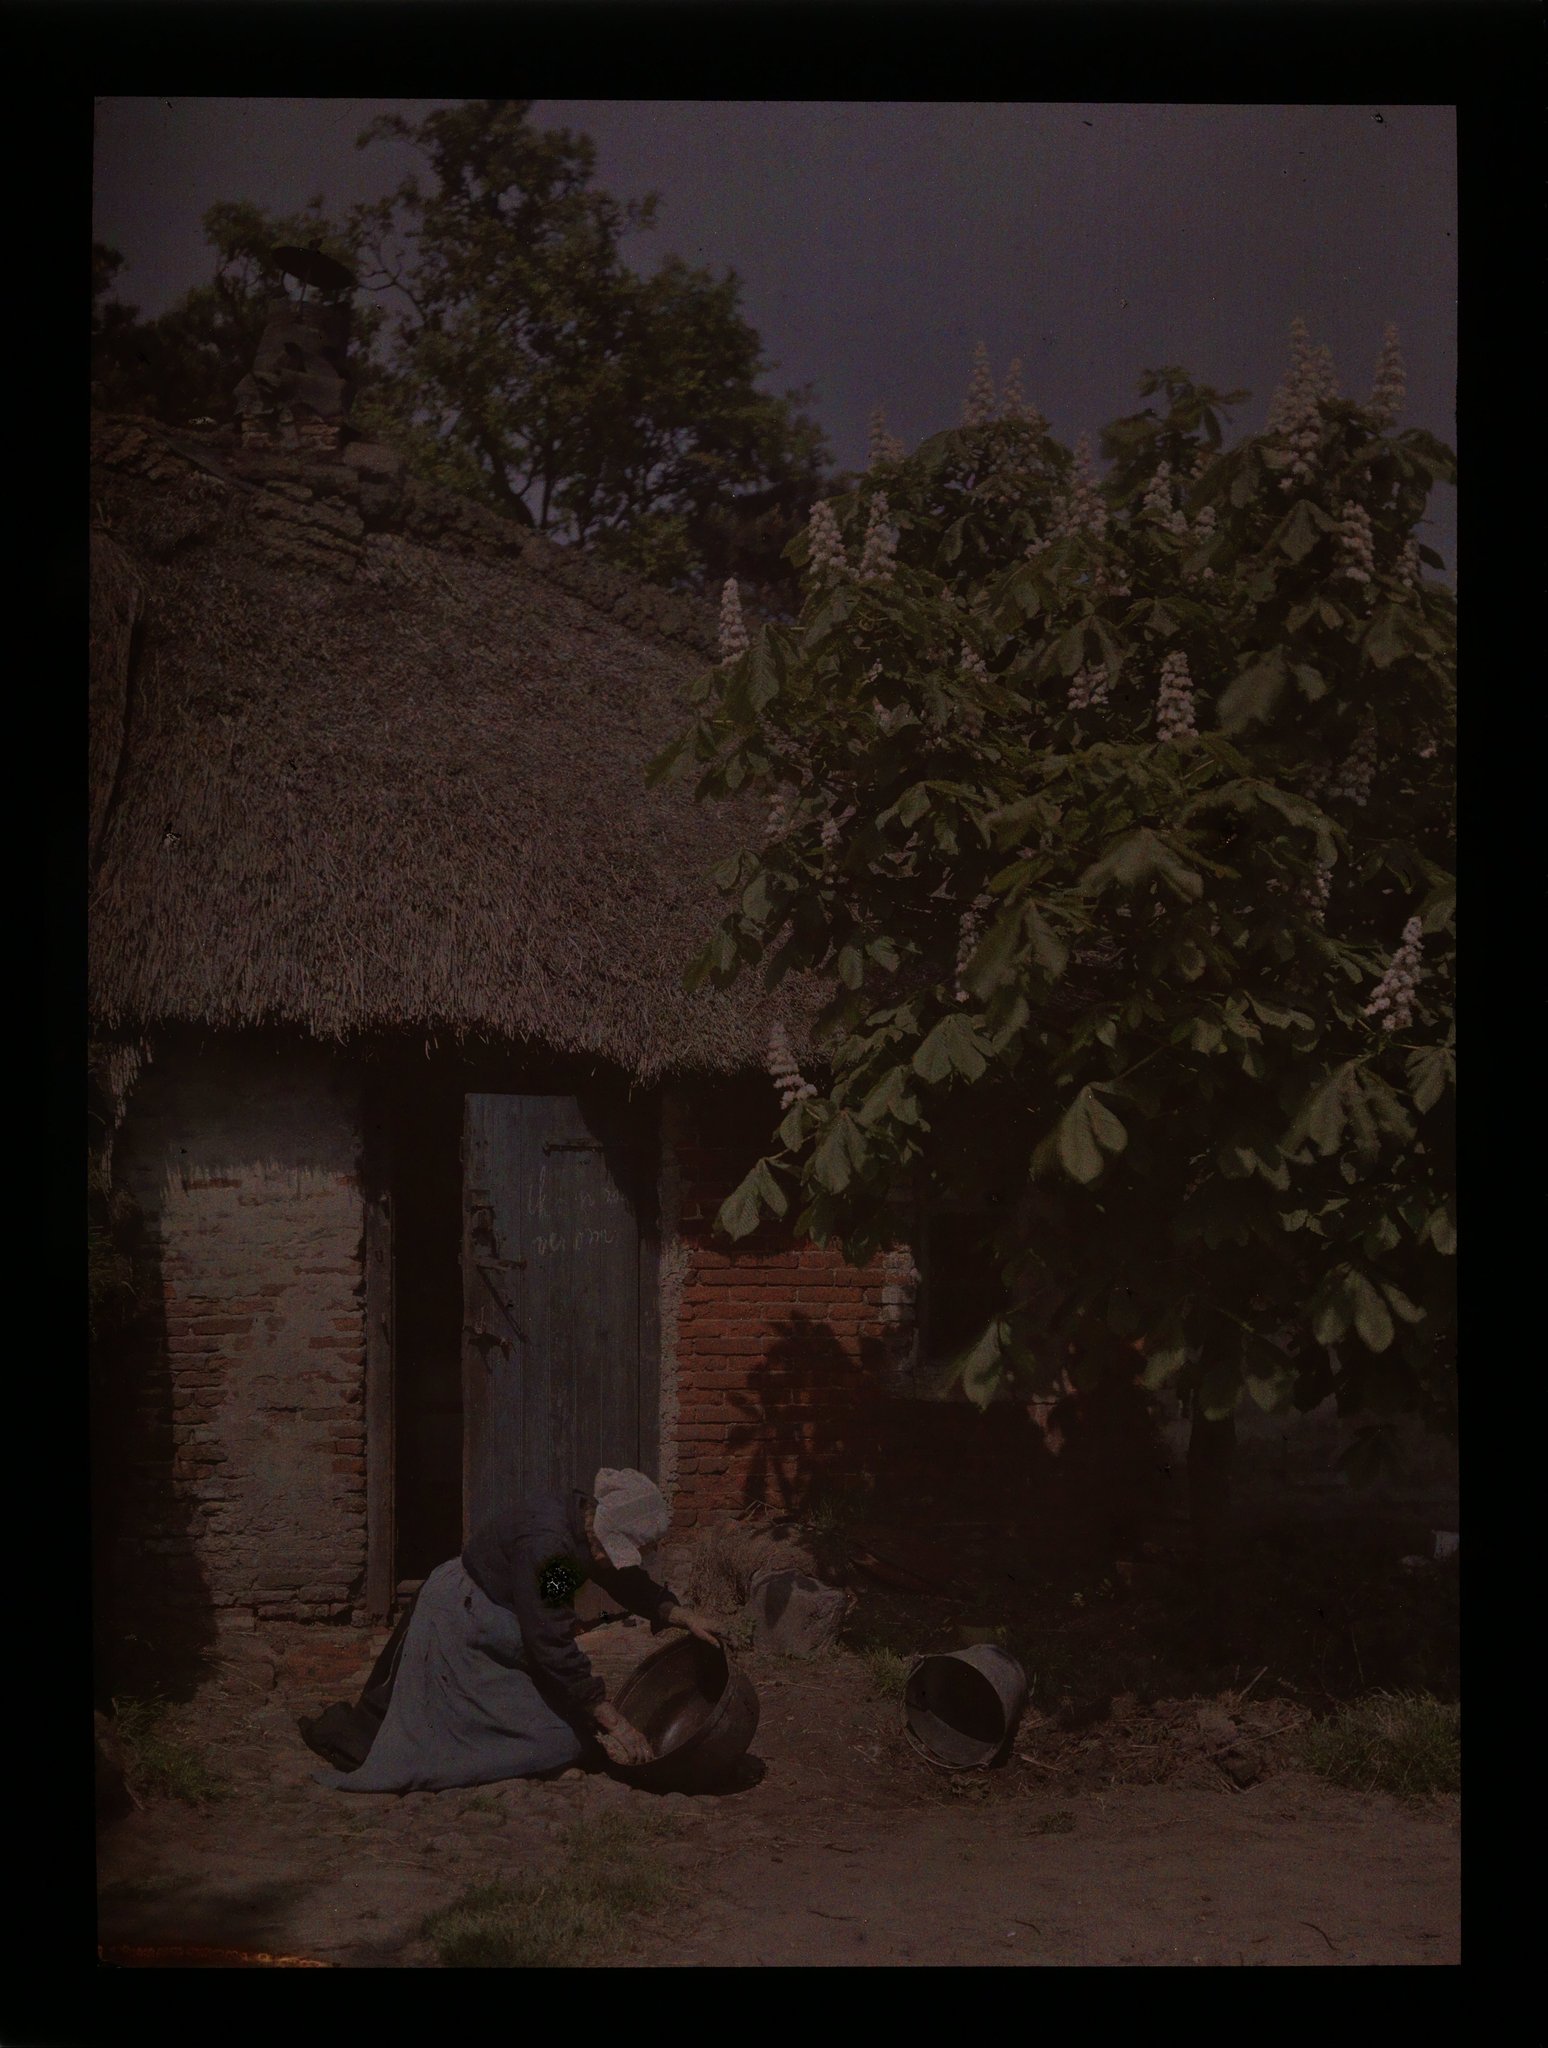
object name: photograph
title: Vrouw met teil voor de deur van woning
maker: Anonymous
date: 1907-1935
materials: glass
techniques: autochrome process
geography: netherlands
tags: cleaning (the house), netherlands